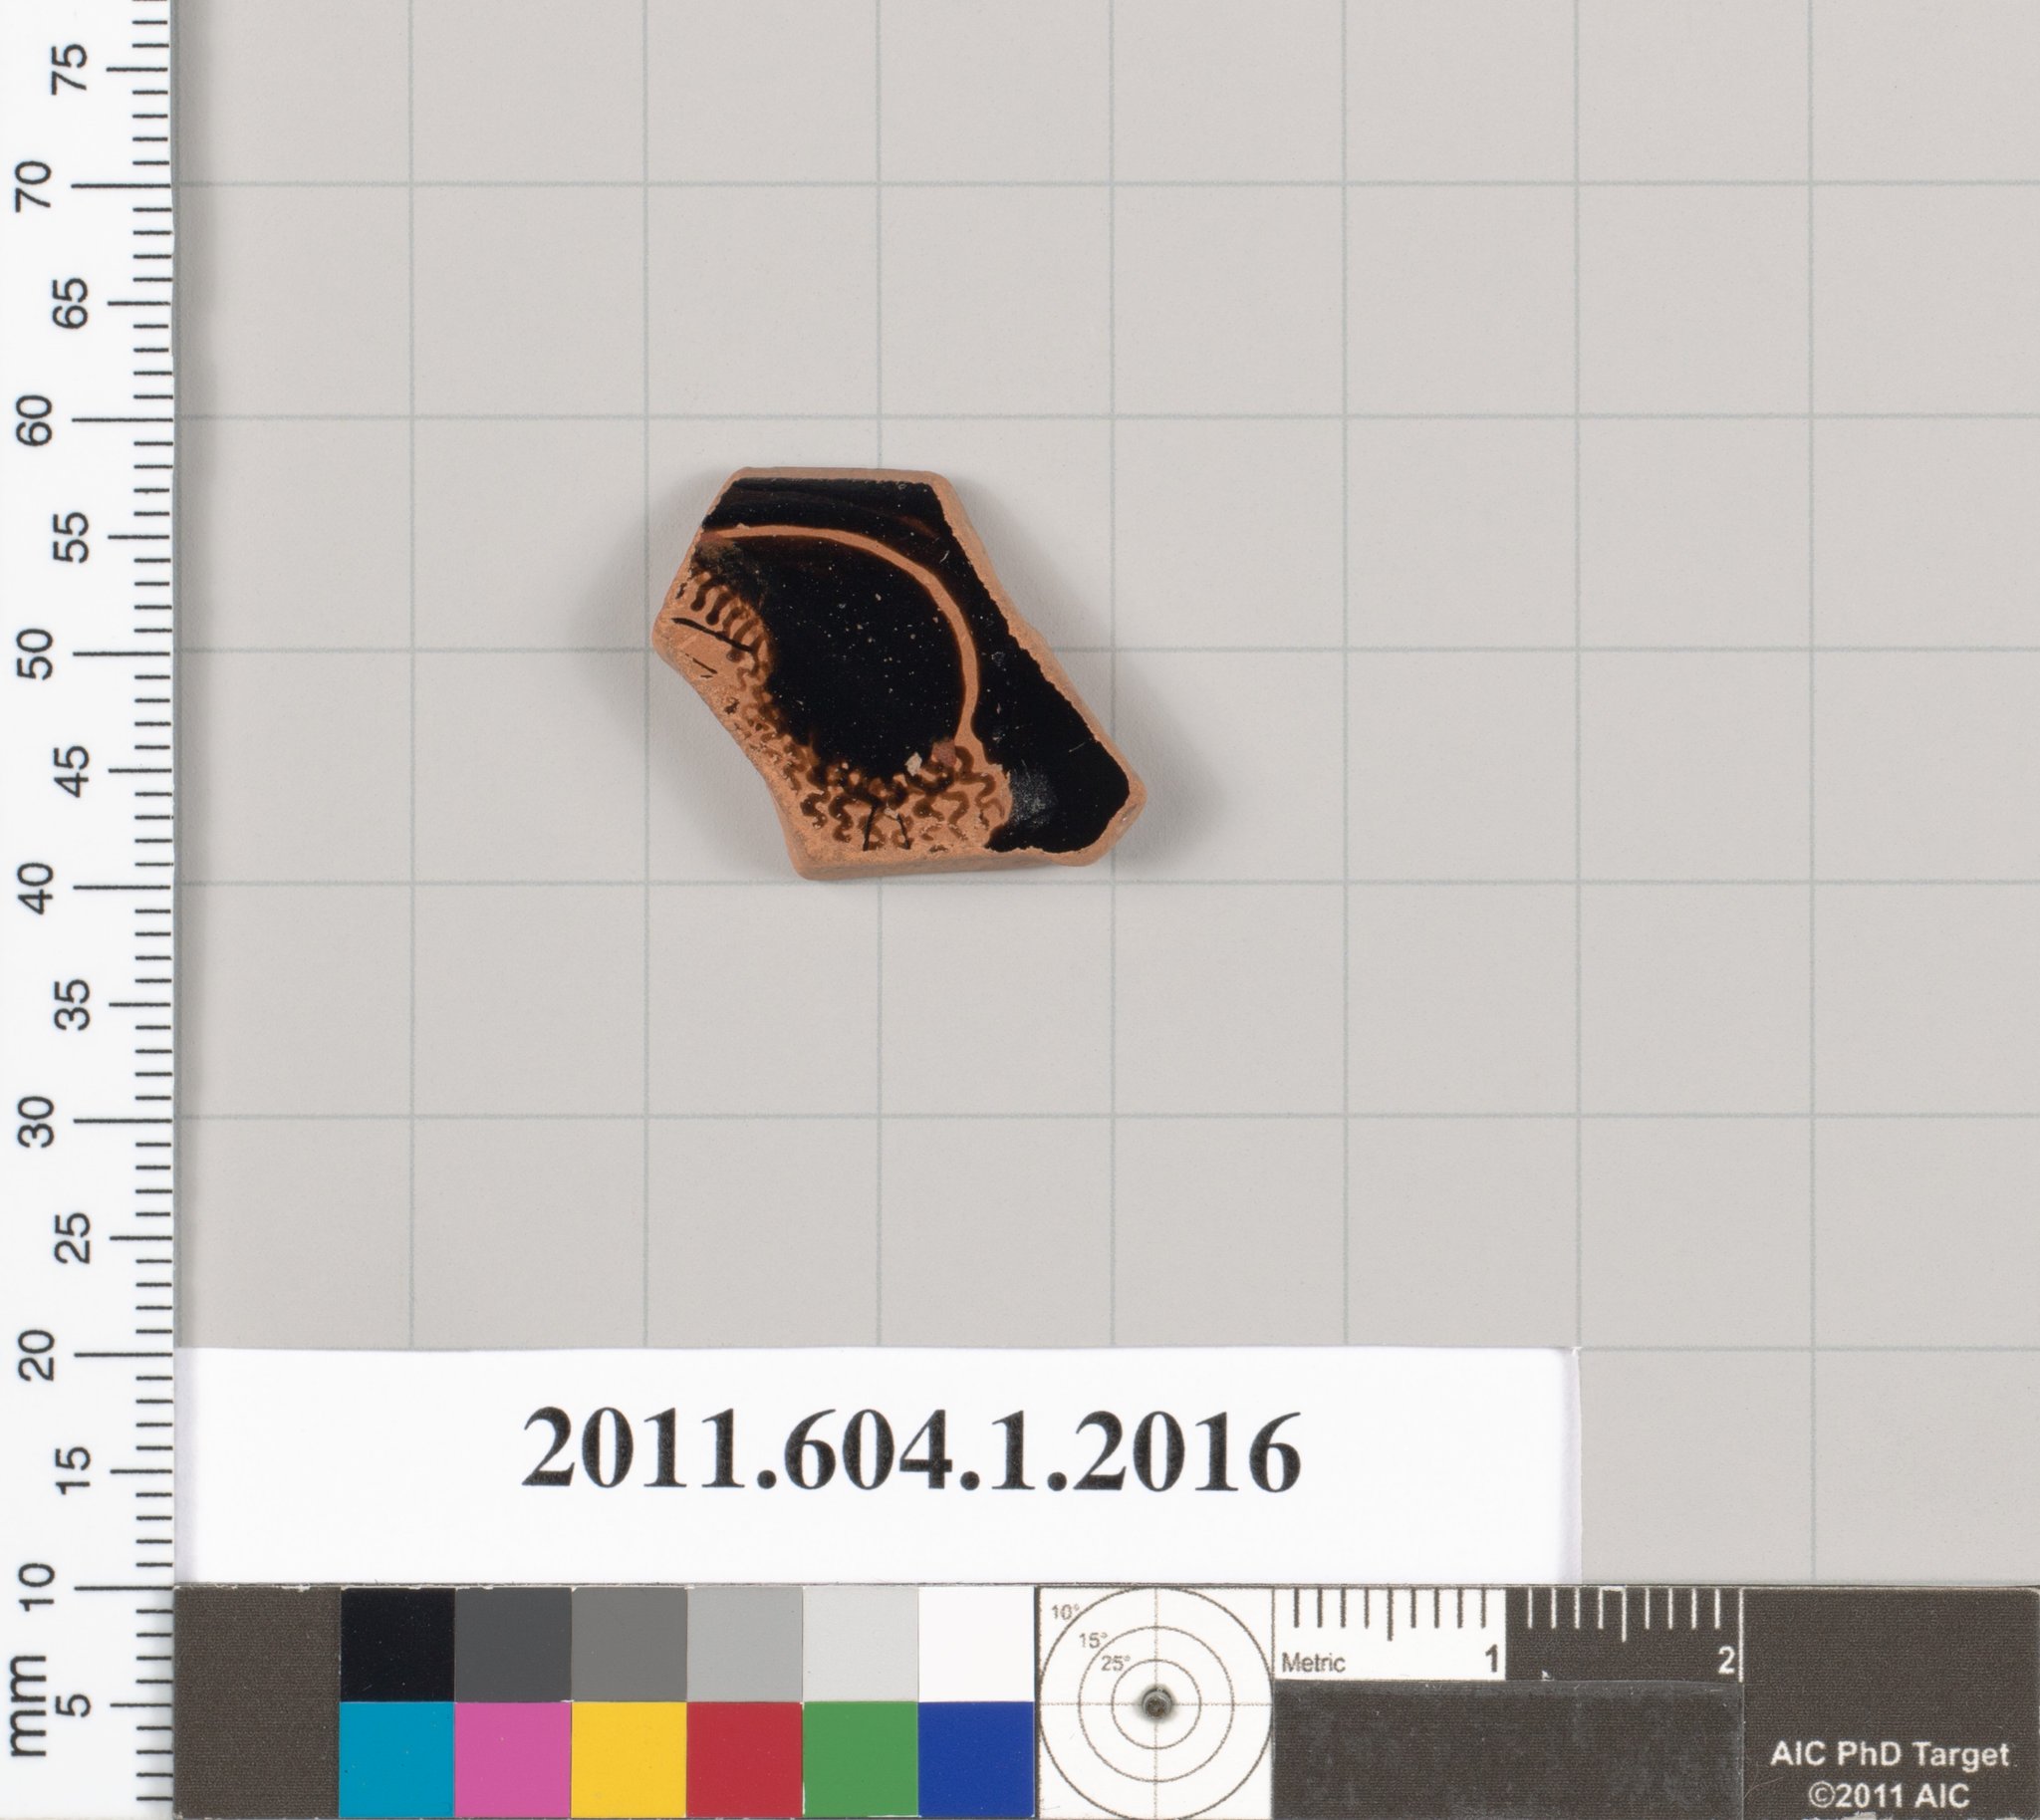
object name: kylix fragment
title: Terracotta rim fragment of a kylix (drinking cup)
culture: greek, attic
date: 467-435 BCE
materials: terracotta